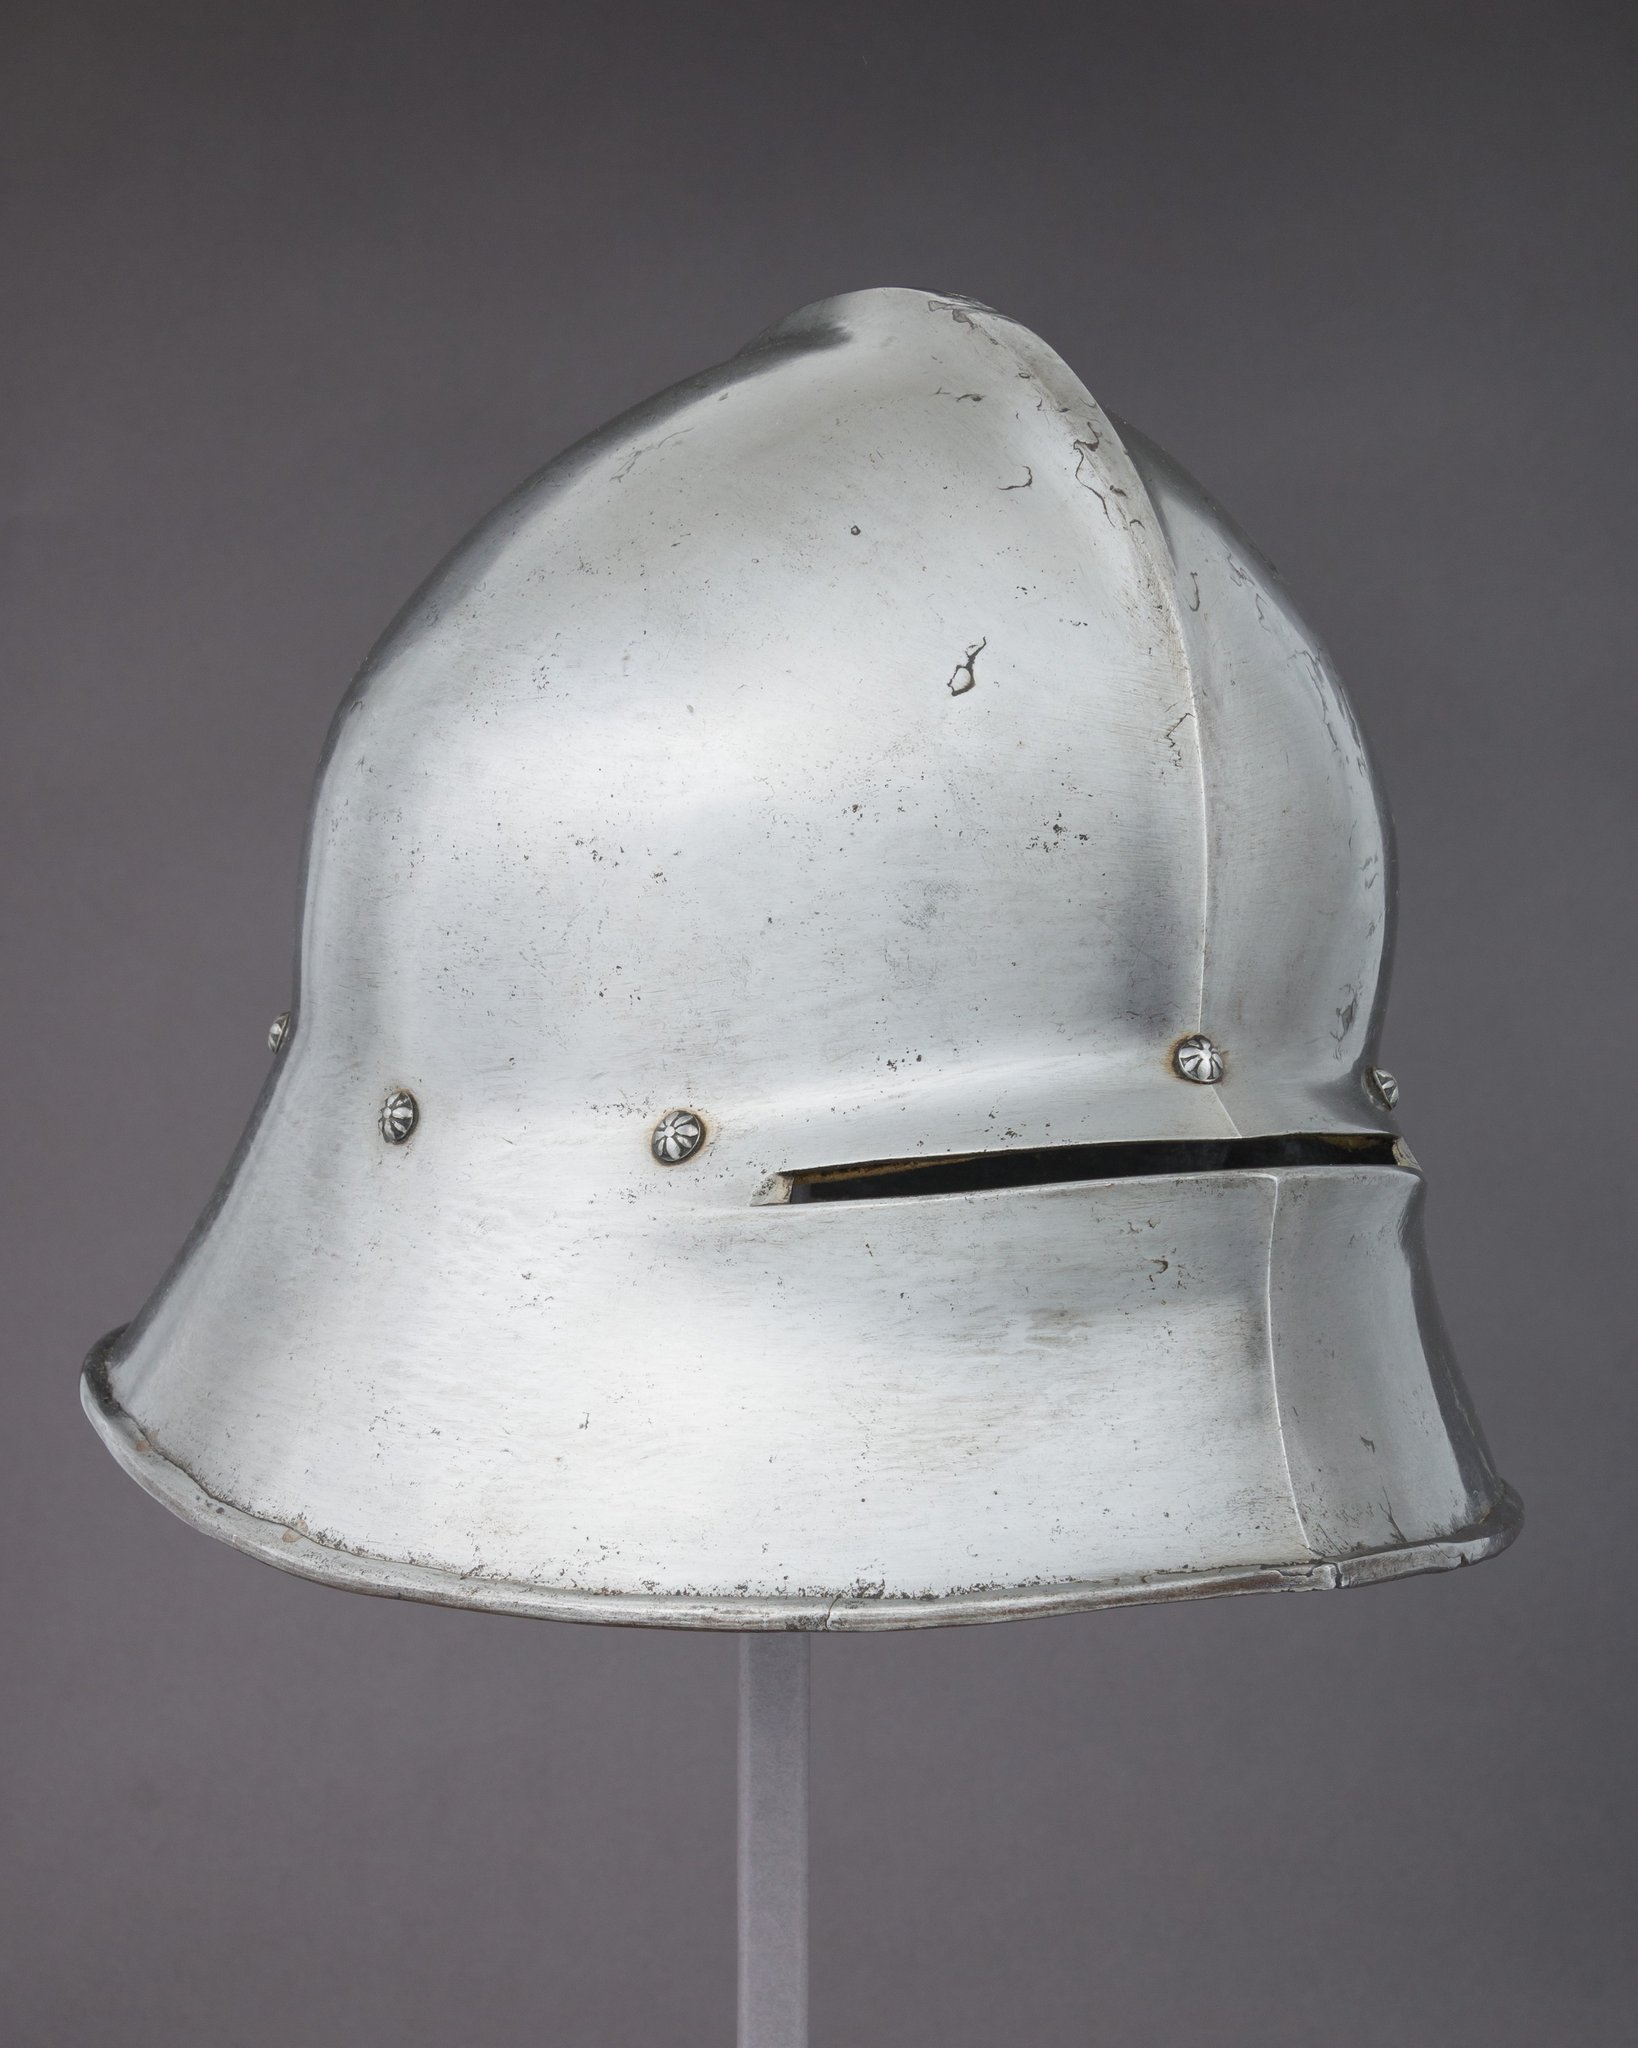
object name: sallet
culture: german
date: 1480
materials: leather, steel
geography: germany